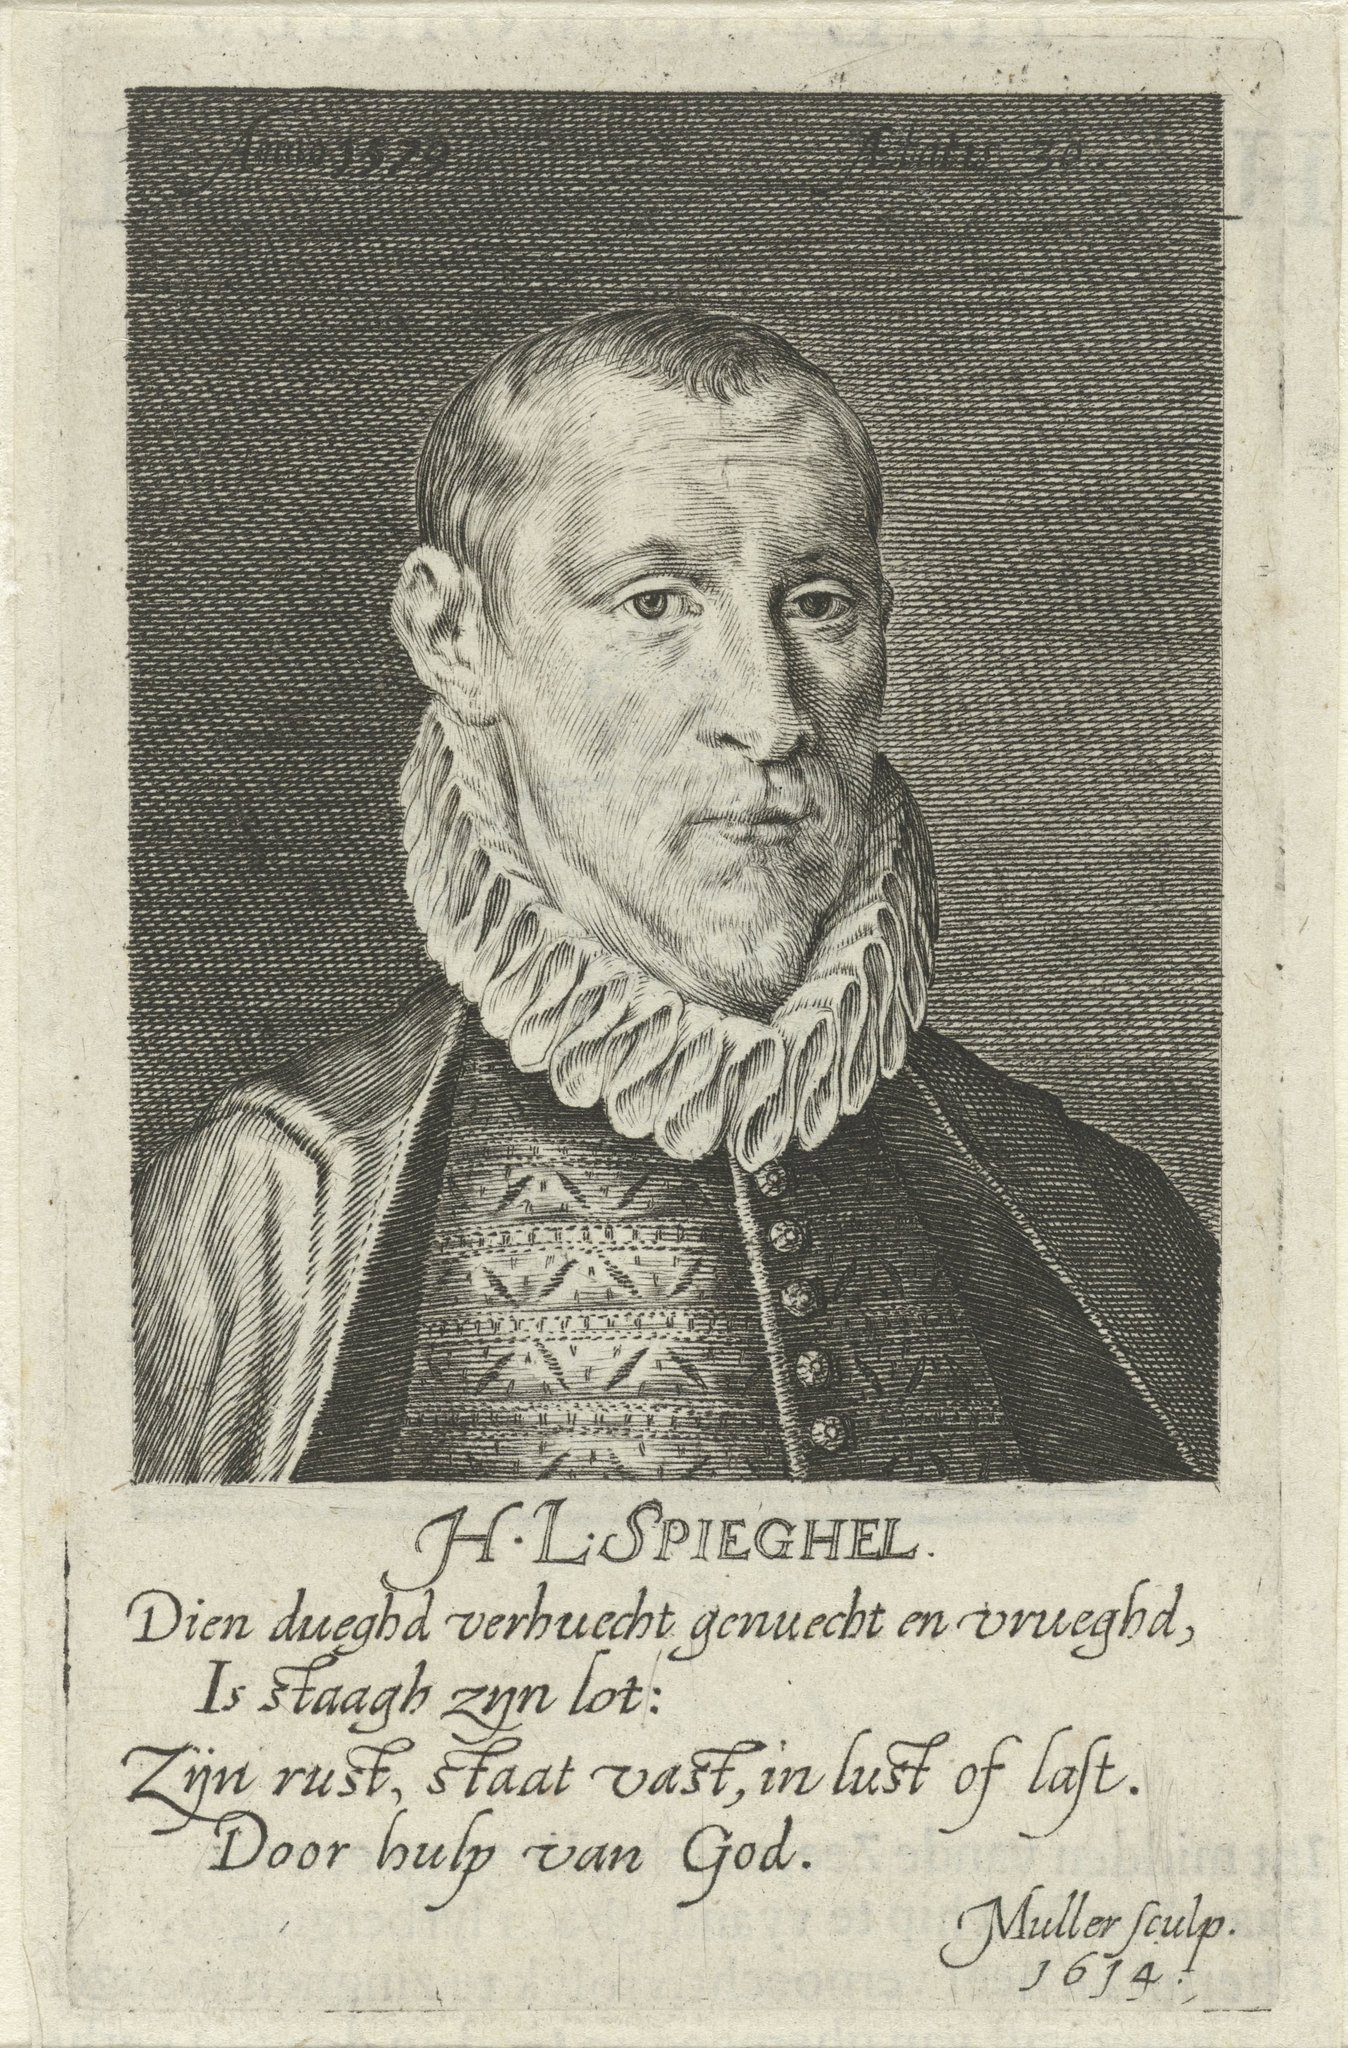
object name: print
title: Portret van Hendrick Laurensz. Spieghel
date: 1614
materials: paper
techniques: engraving, letterpress printing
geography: amsterdam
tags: amsterdam, hendrick laurensz. spieghel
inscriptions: collector's mark: Lugt 2228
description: Prent gebruikt in een van de edities van: Spieghel, Hendrick Laurensz. Hart-spieghel. Amsterdam: Cornelis Dircksz Cool (I), 1614. Op verso een houtsnede van Arion op de dolfijn.